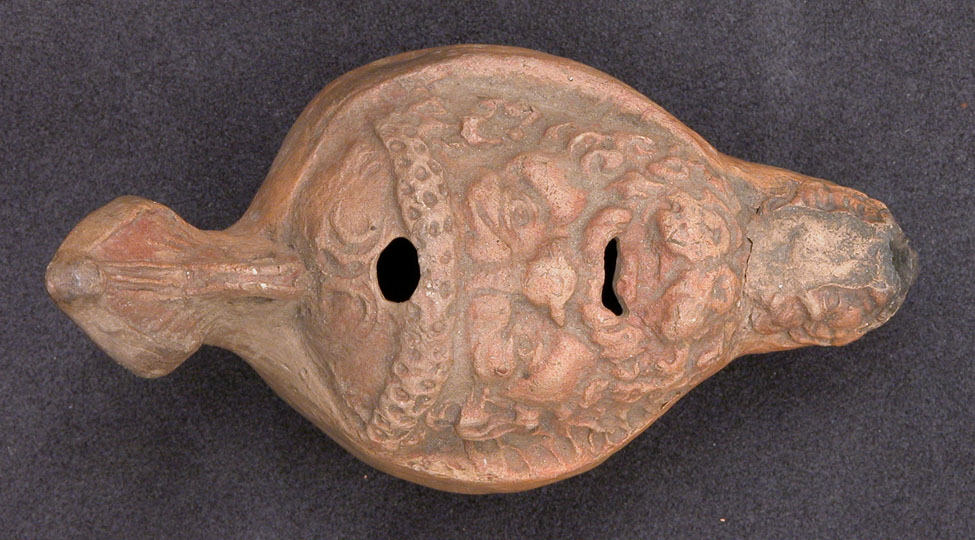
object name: lamp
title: Lamp in the Form of a Mask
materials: earthenware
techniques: molding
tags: masks